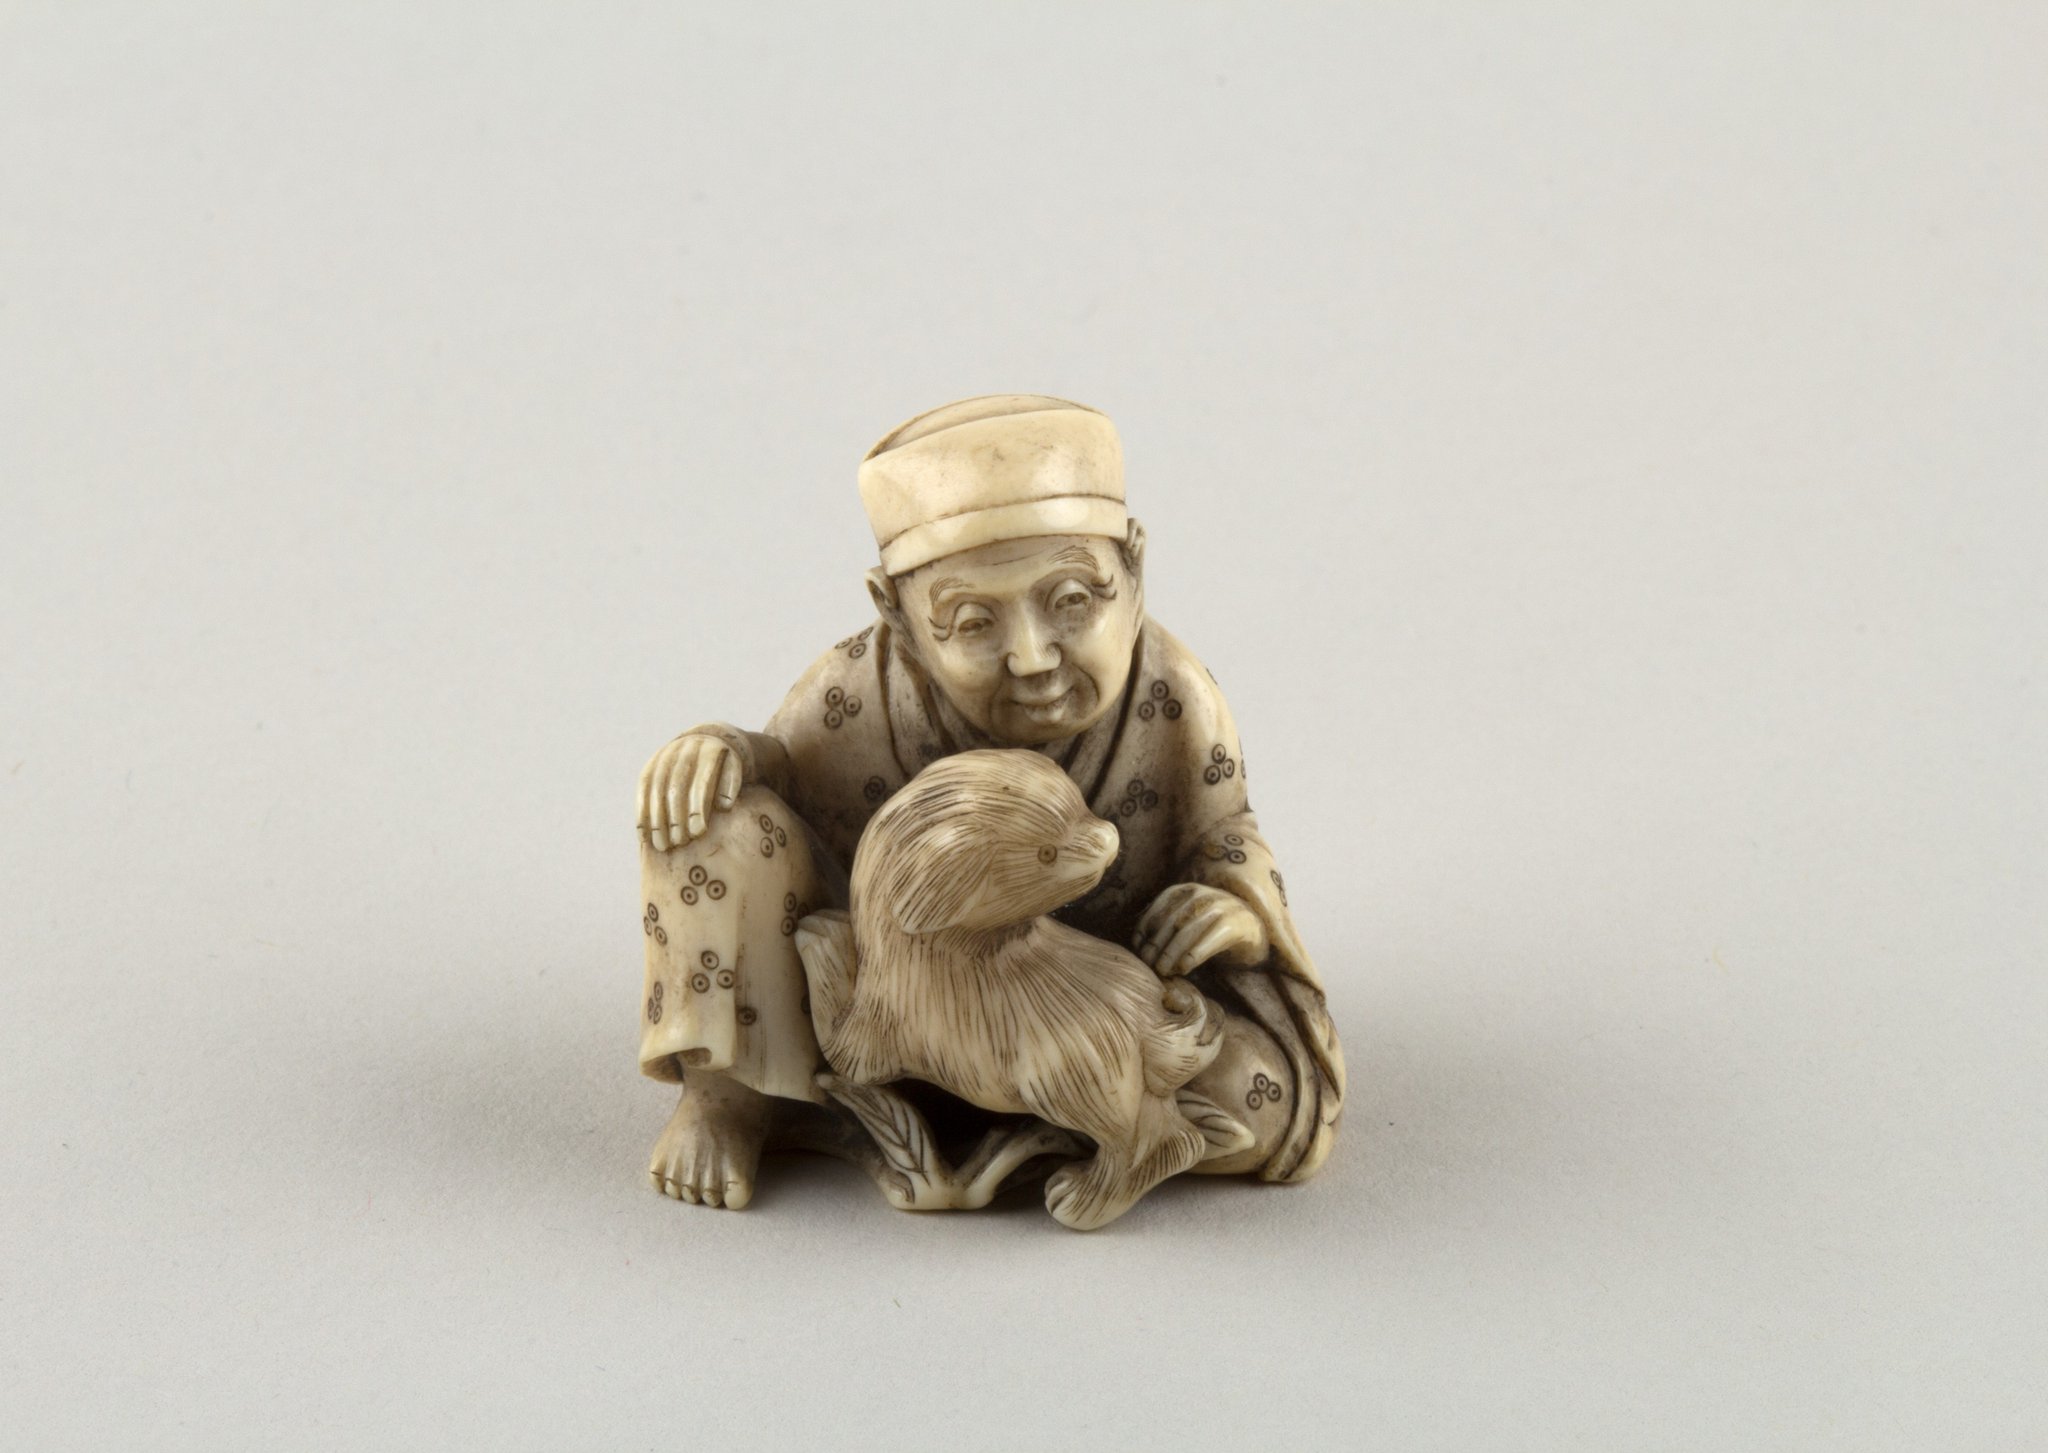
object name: netsuke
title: Seated figure of a Man with Dog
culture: japanese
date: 1801-1900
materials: ivory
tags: men,dogs